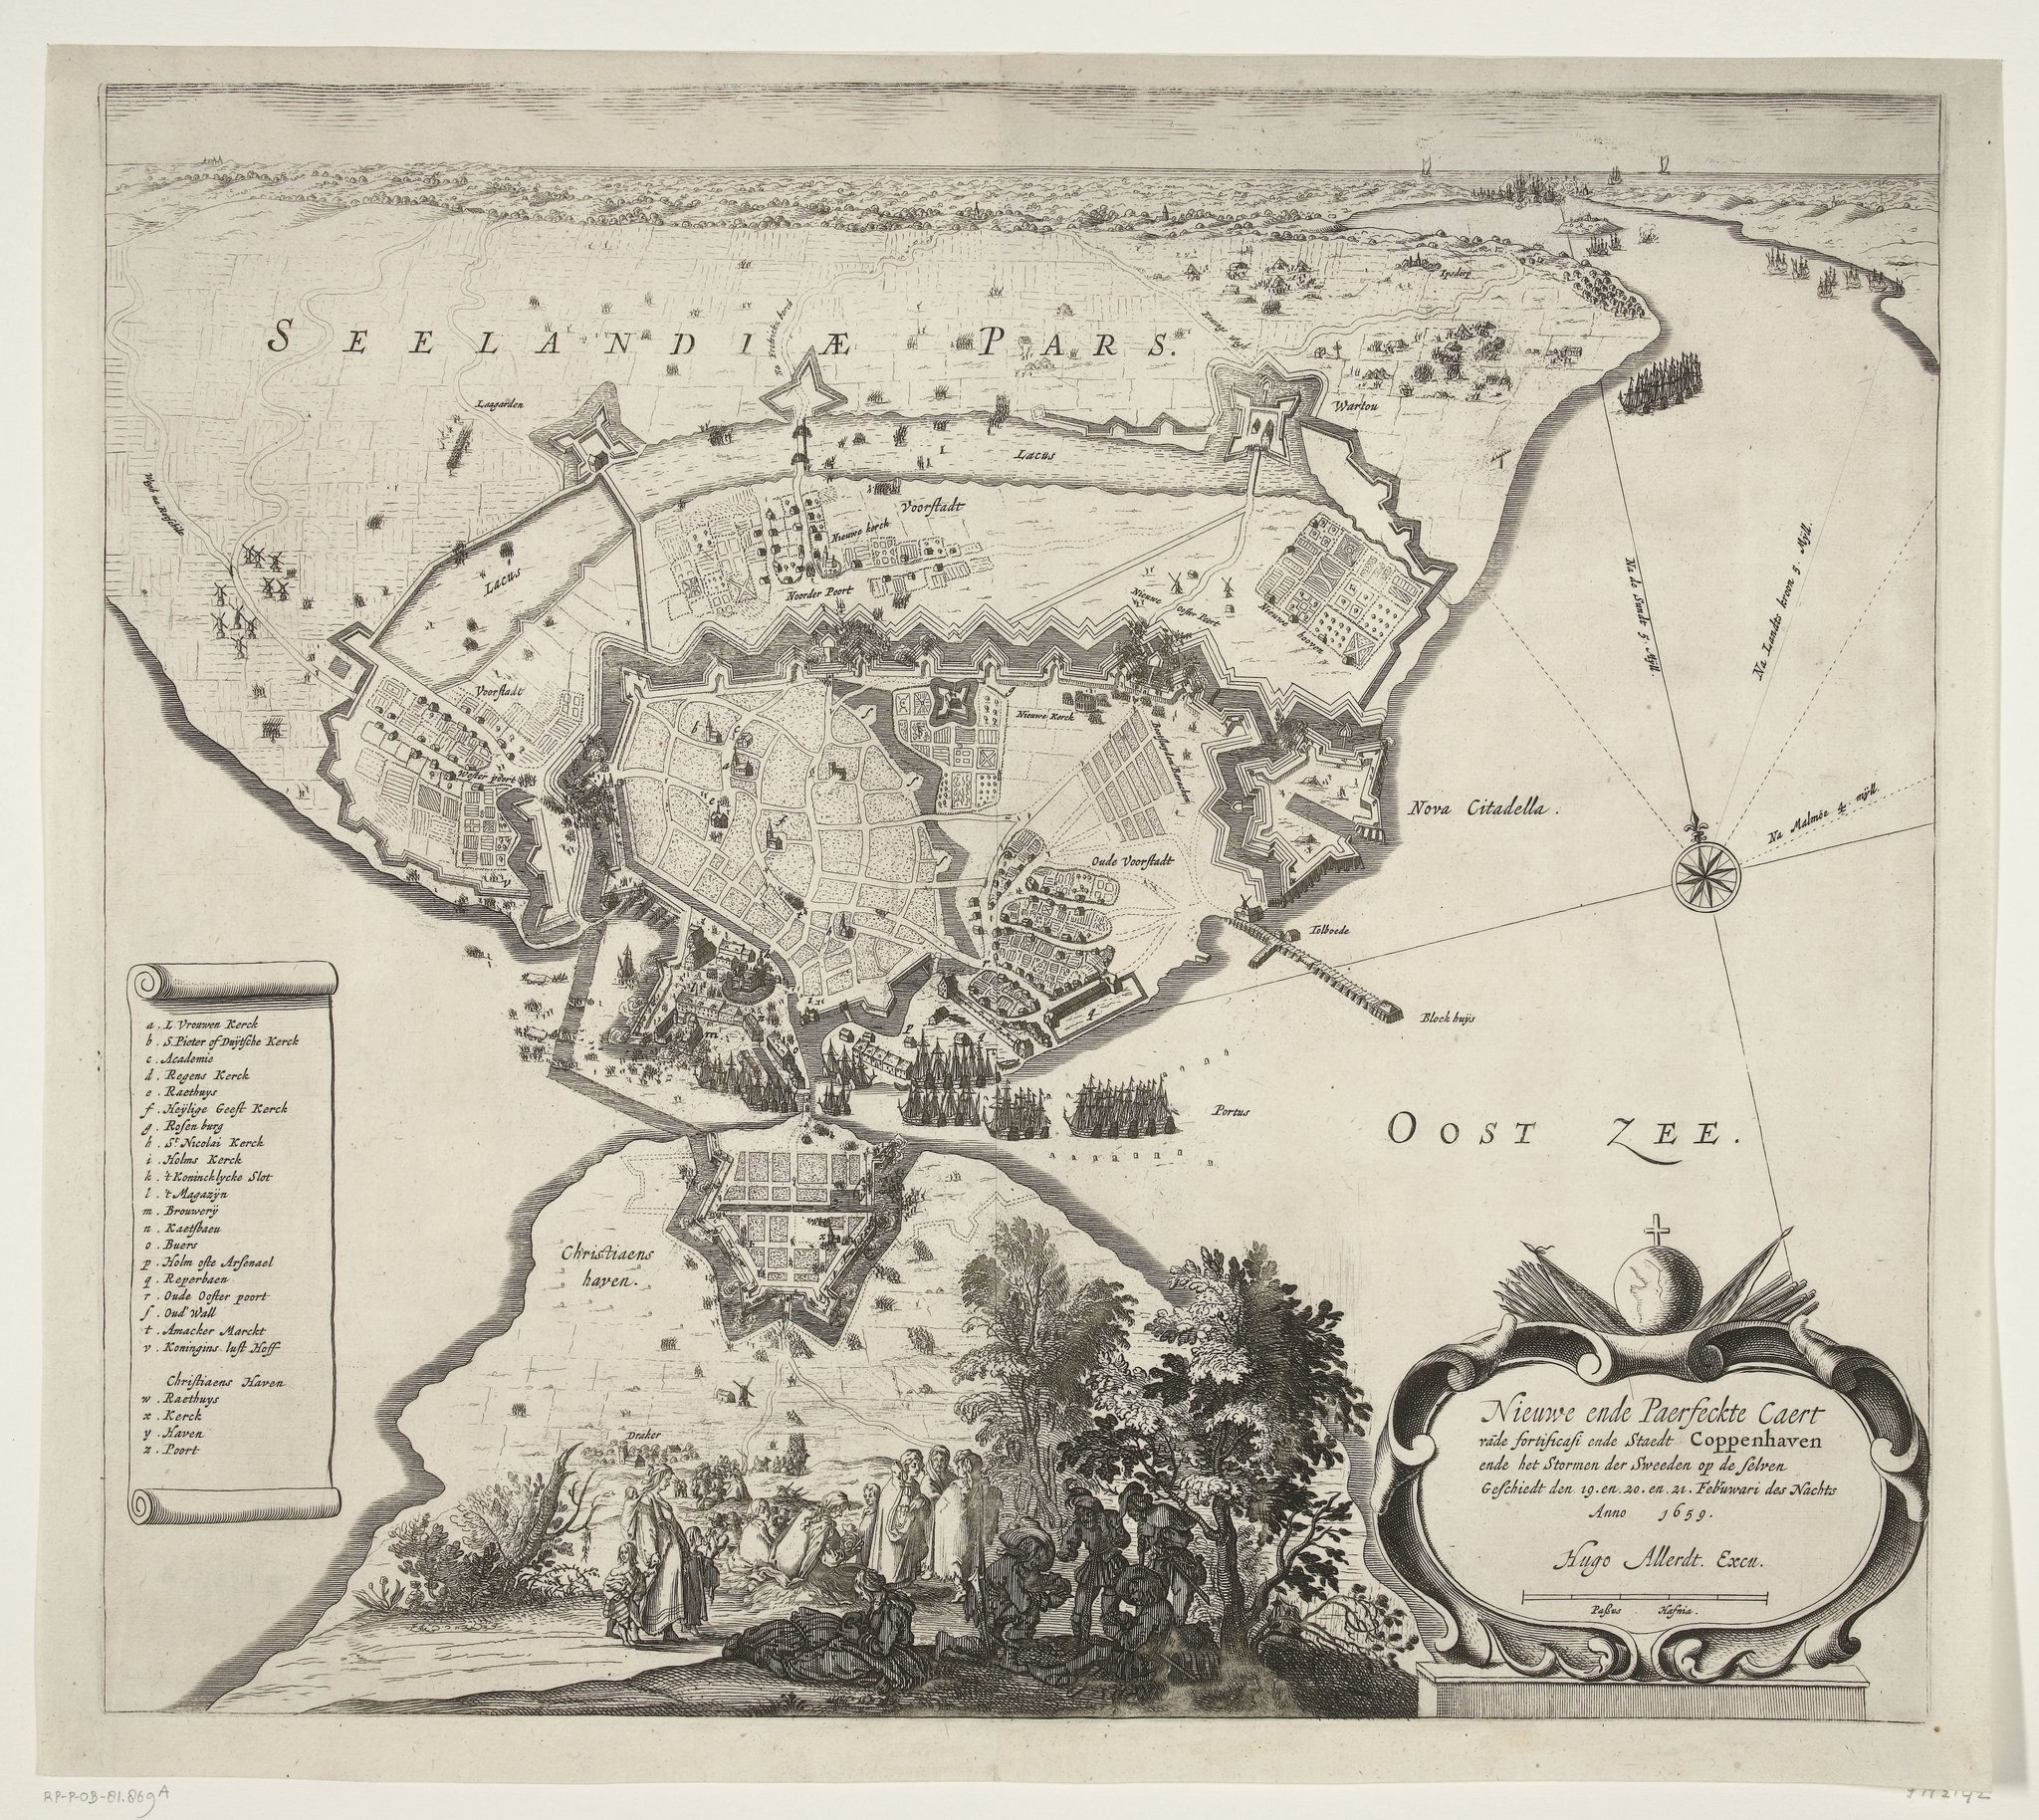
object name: print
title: Ontzet van Kopenhagen, 1659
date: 1659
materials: paper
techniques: engraving, etching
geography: amsterdam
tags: maps of cities, copenhagen (city)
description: Plattegrond van Kopenhagen met de Hollandse vloot die de belegering van de stad door de Zweden doorbreekt, 19-21 februari 1659. Op de voorgrond kaartende soldaten onder een boom en vrouwen met kinderen. Links de legenda a-z. Bij de prent behoren twee tekstbladen.